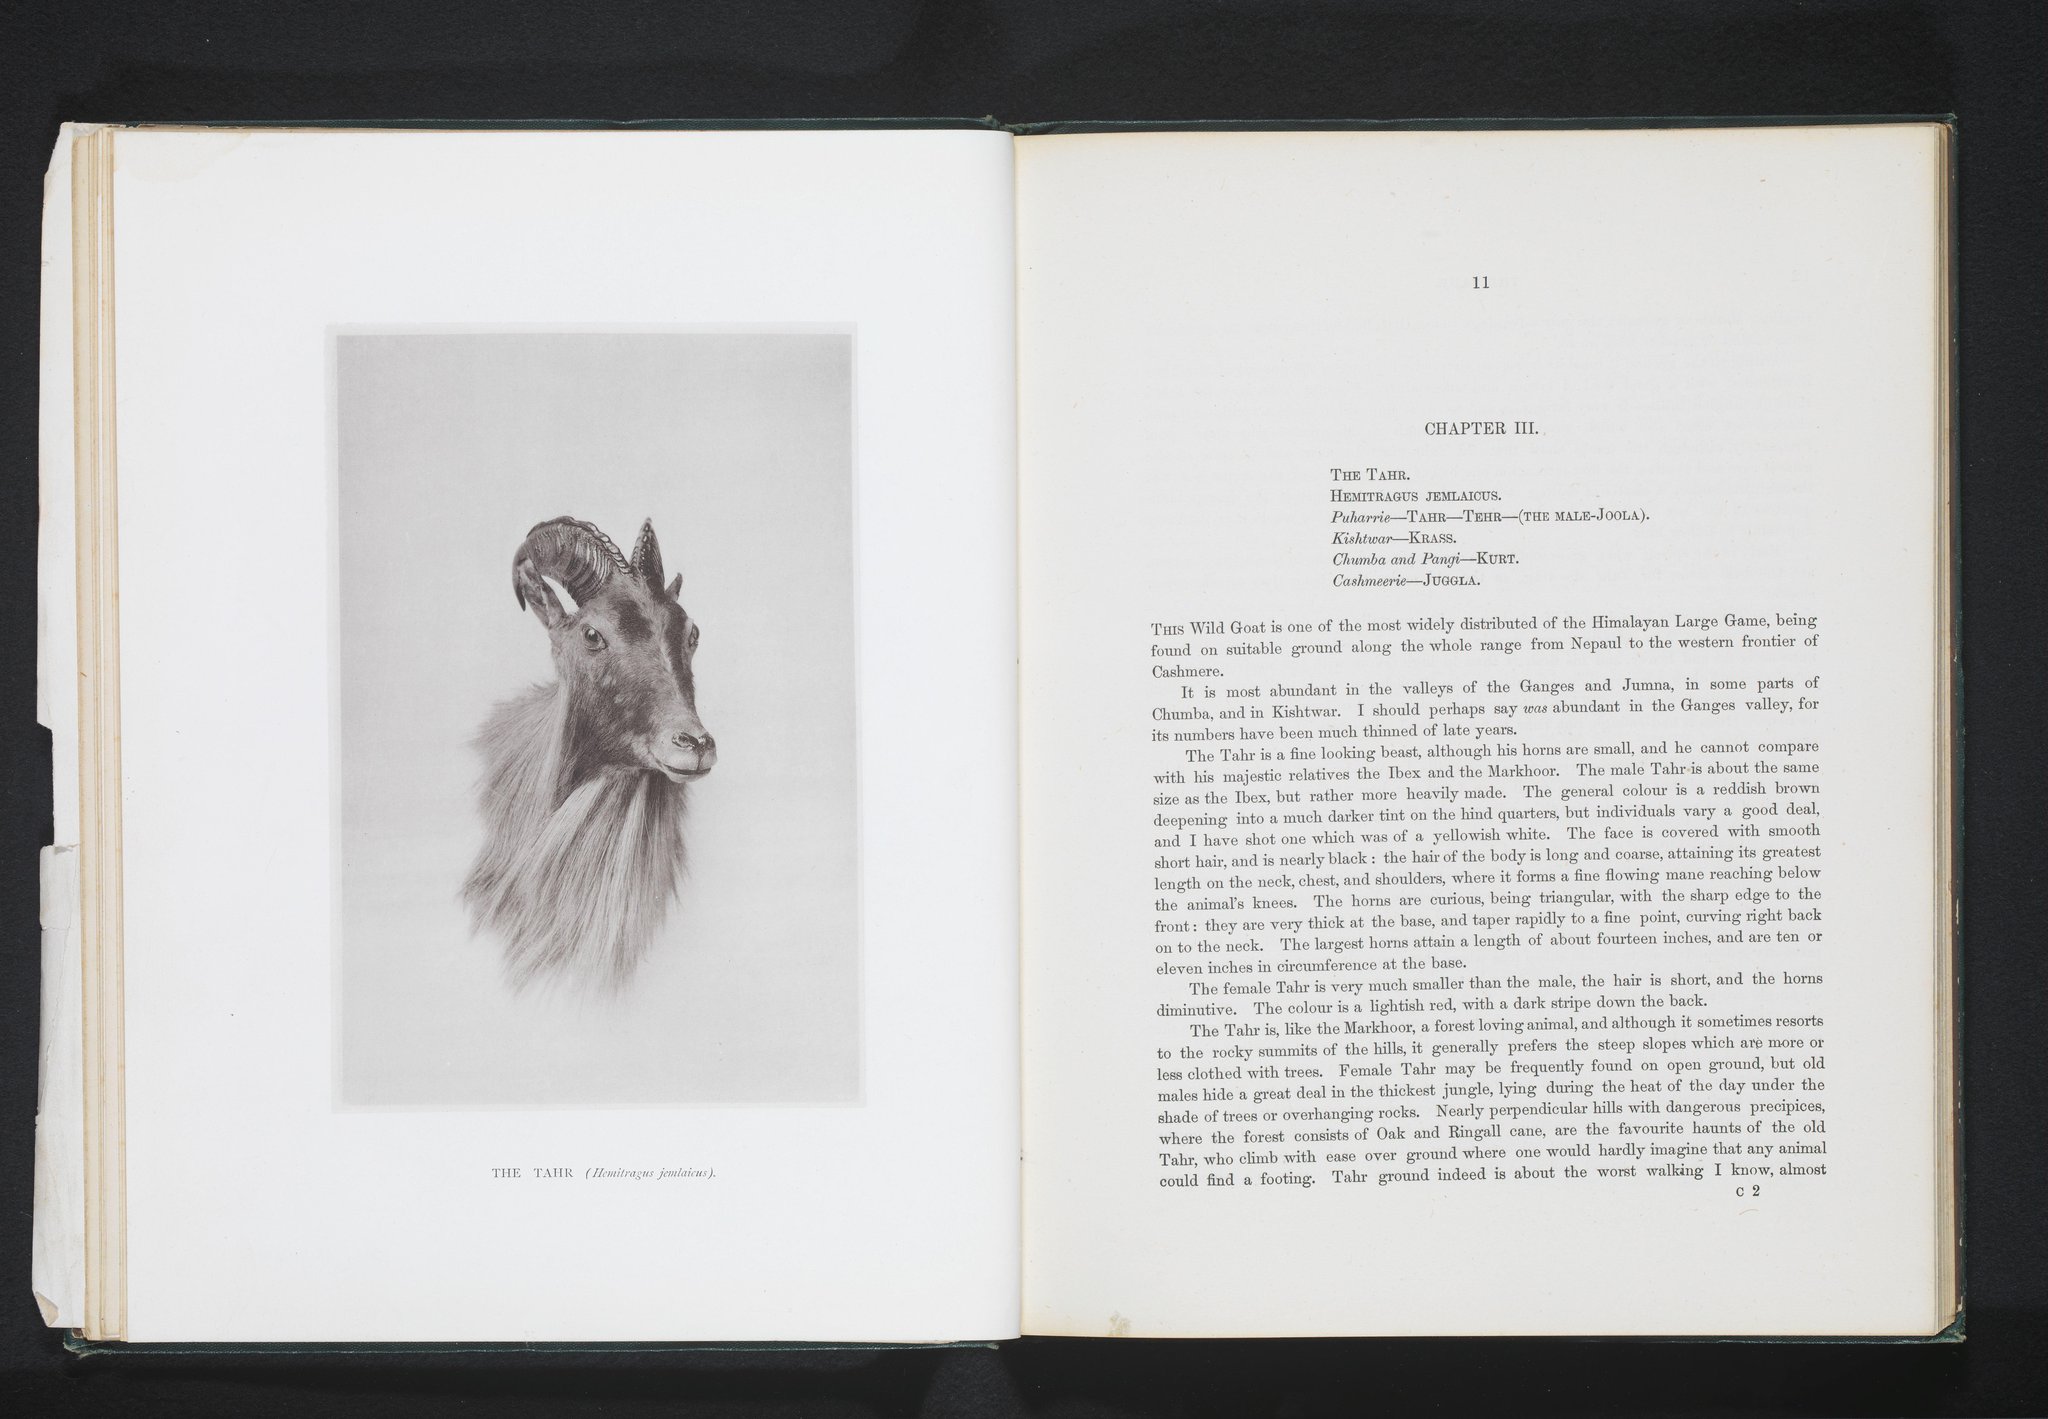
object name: page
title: The tahr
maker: Anonymous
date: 1865-1876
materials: paper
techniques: photograph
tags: goat